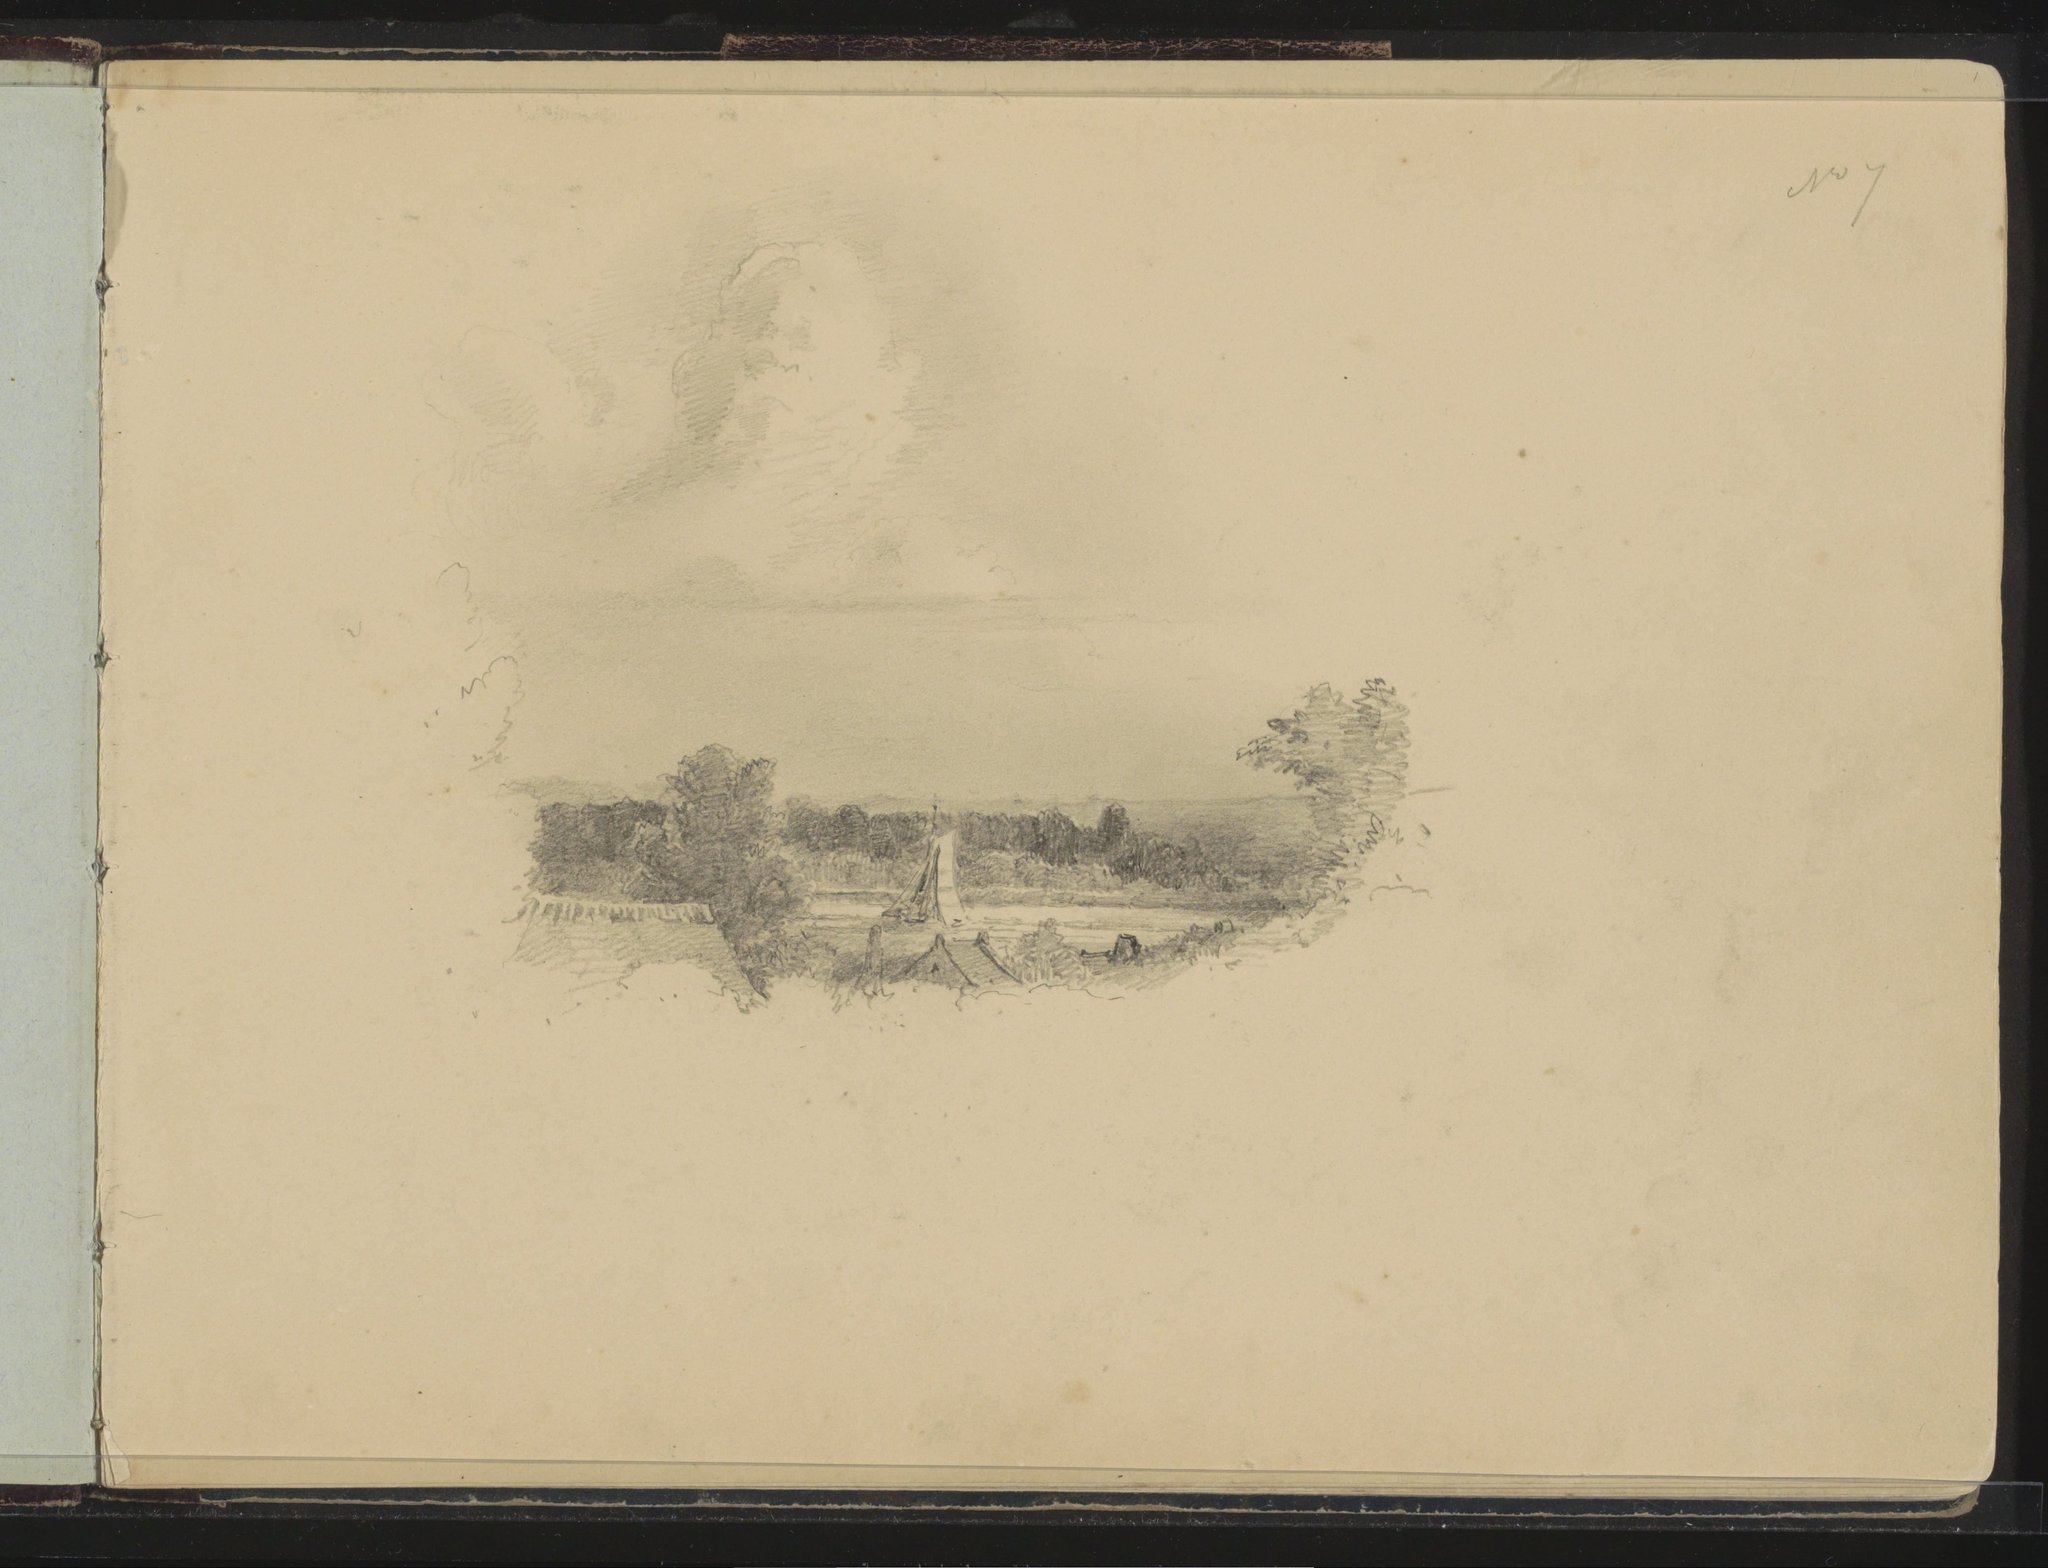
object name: sketchbook leaf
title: Landschap met een zeilschip op een rivier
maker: maria vos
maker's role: draughtsman, painter, print maker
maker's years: 1824-1906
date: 1864-1865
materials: paper, pencil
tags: sailing-ship, sailing-boat, landscapes with waters, waterscapes, seascapes (in the temperate zone)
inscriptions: annotation: ‘No 7’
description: Blad 1 recto uit een schetsboek met 44 bladen.